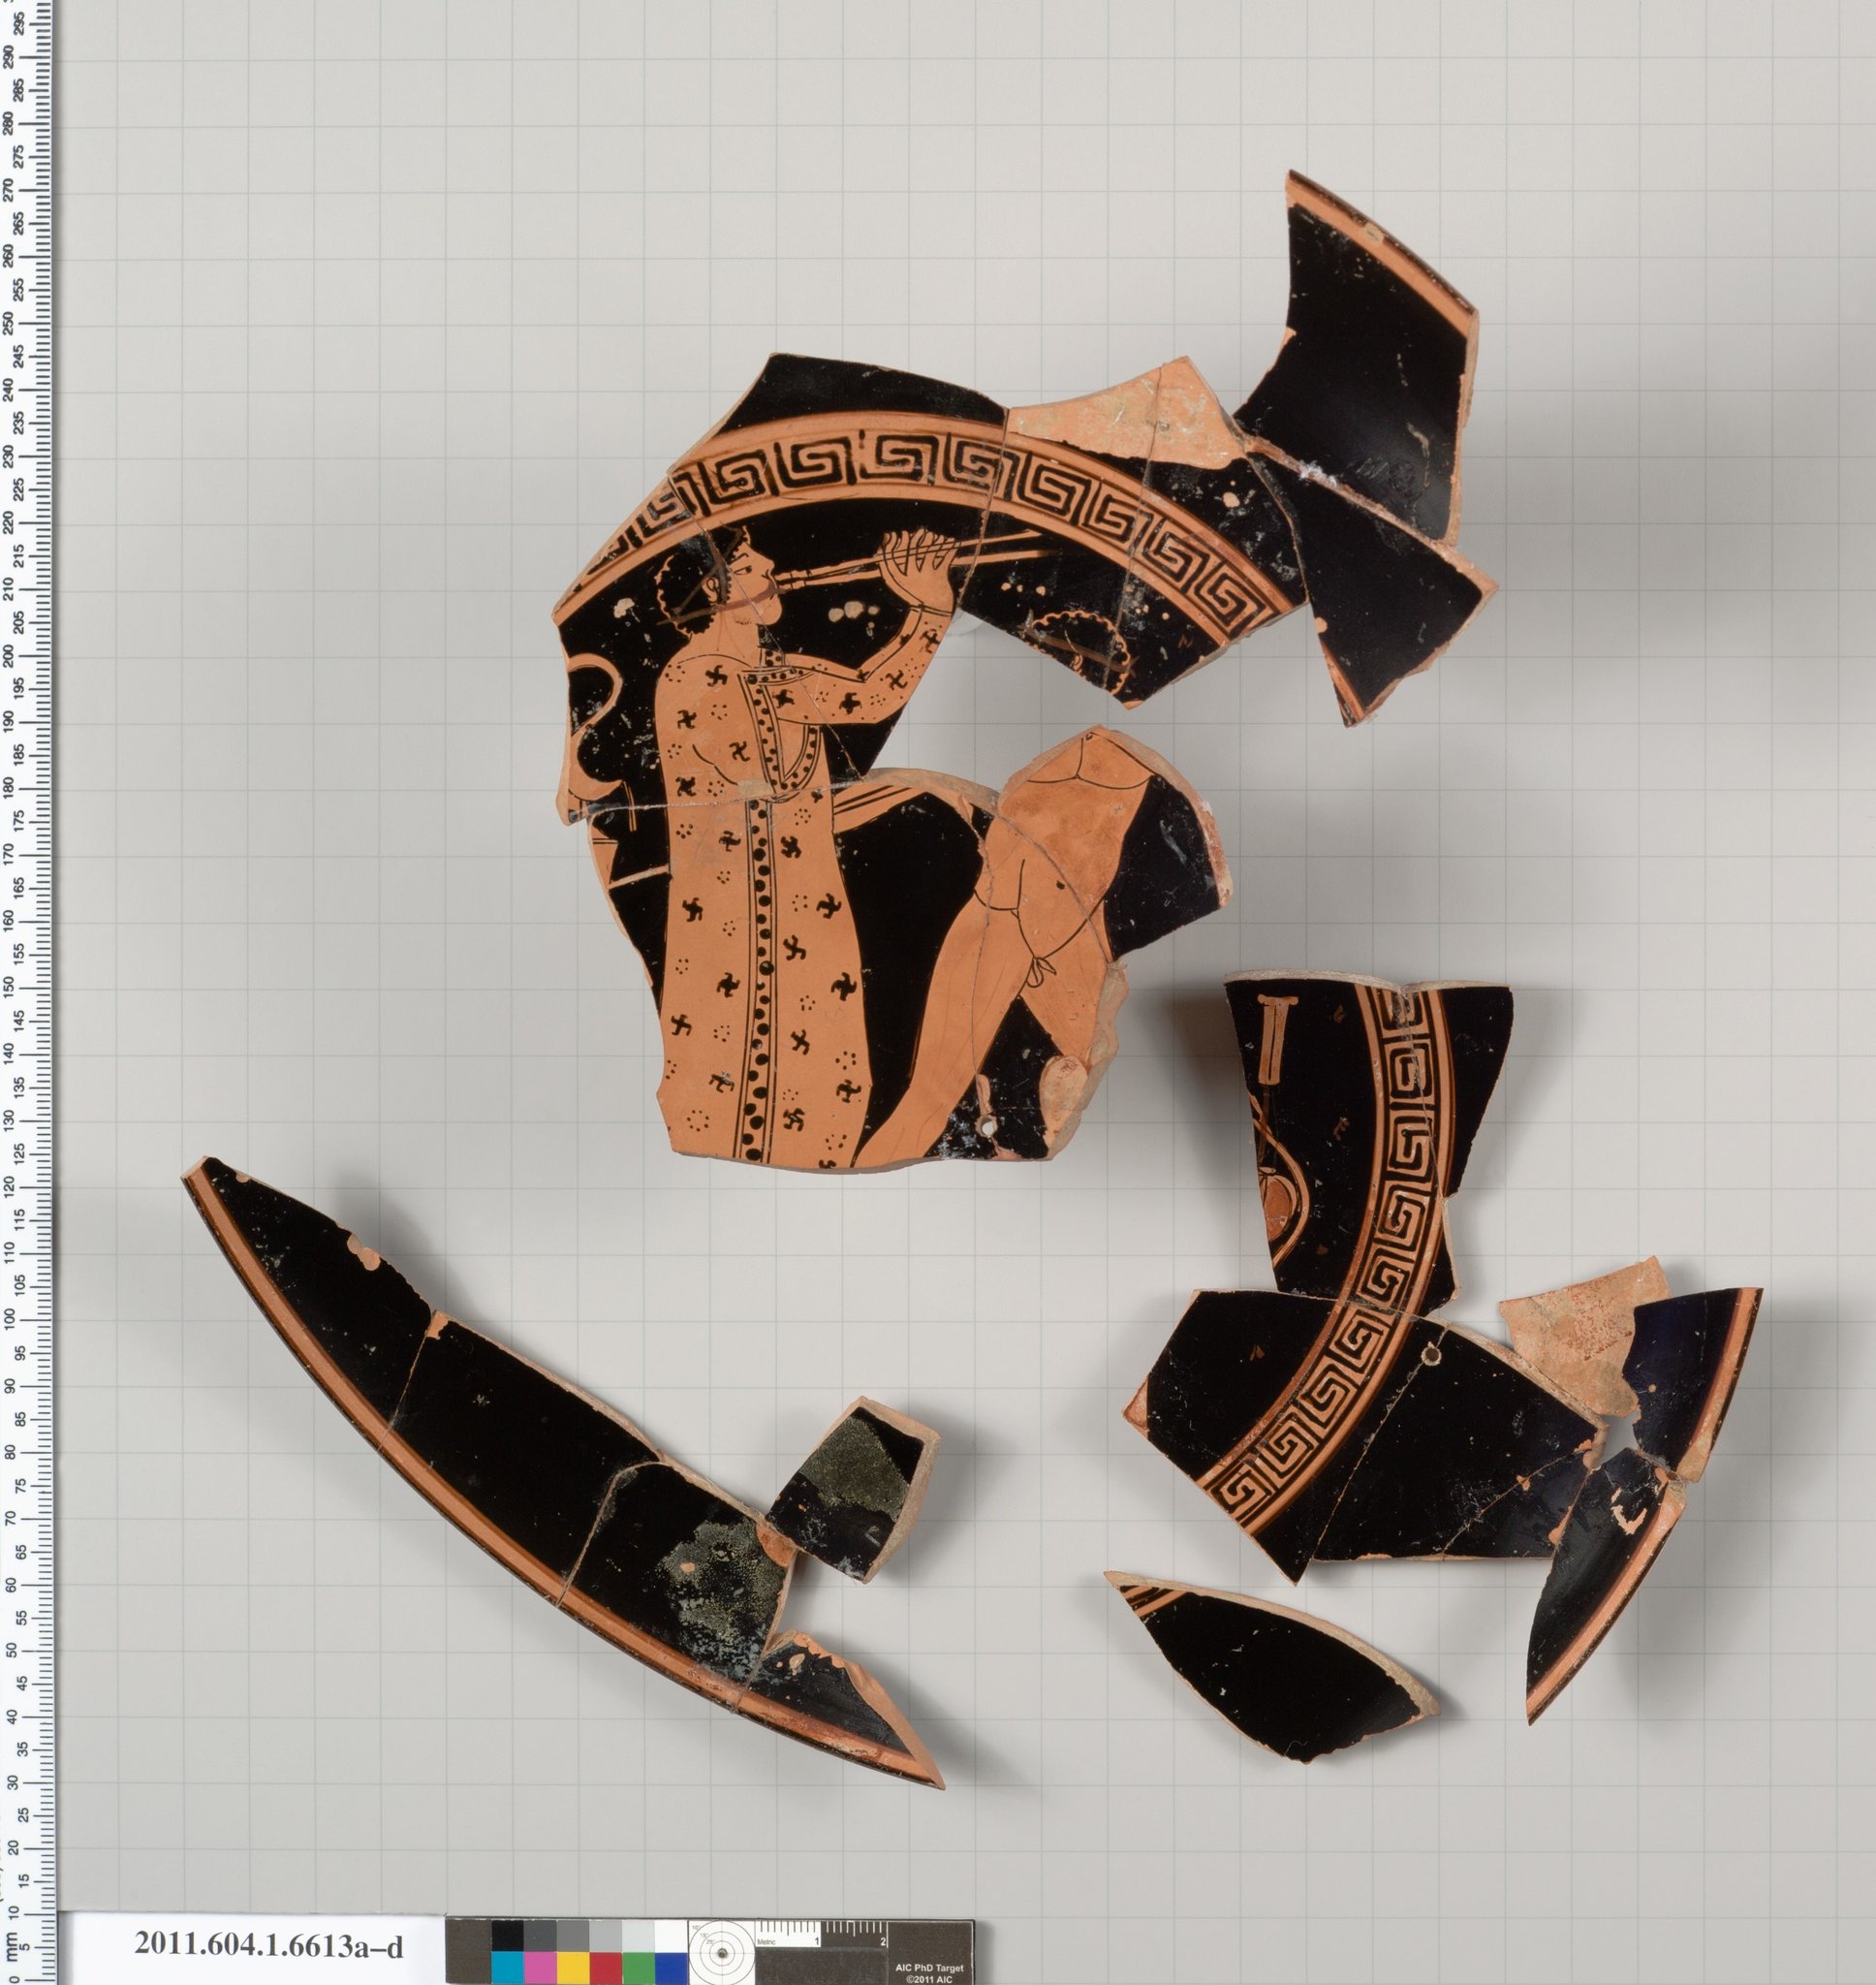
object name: kylix fragment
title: Terracotta fragments of a kylix (drinking cup)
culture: greek, attic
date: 490-470 BCE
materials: terracotta